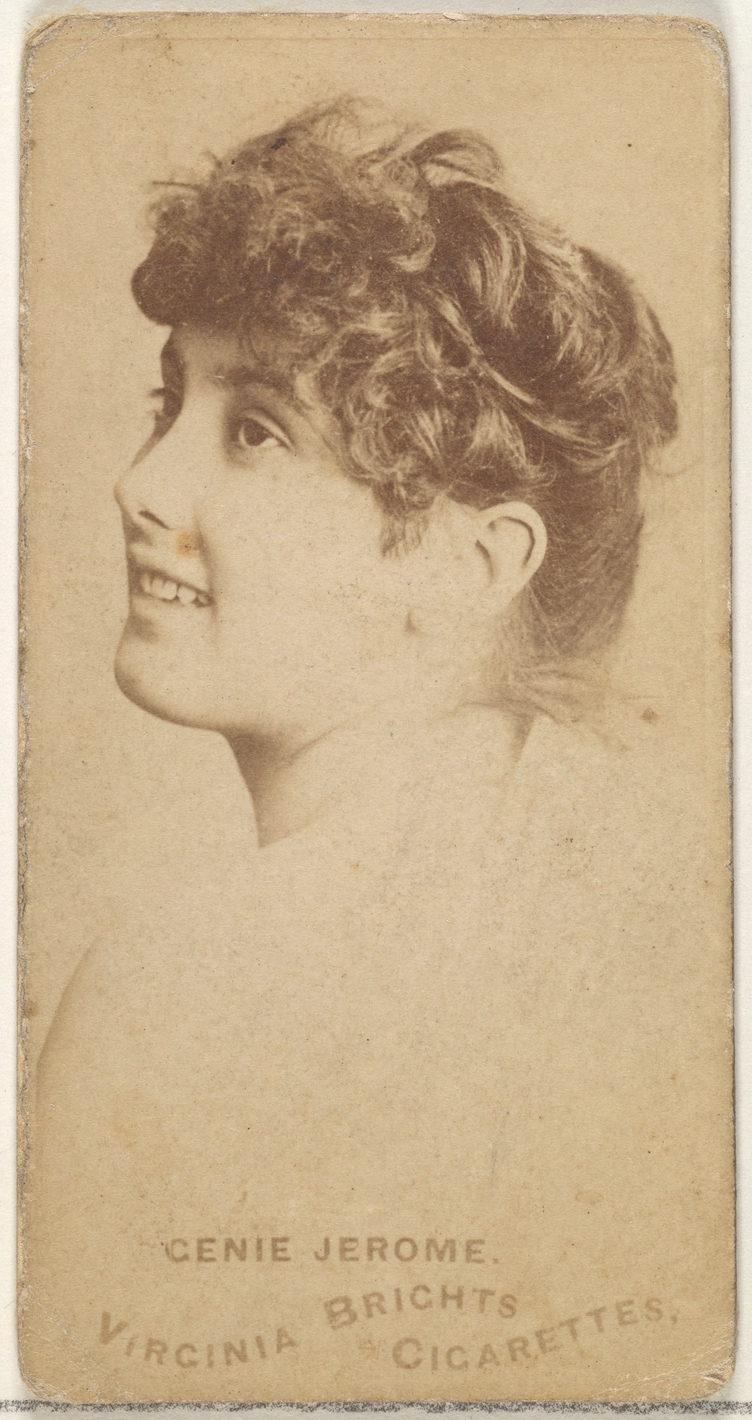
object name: photograph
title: Genie Jerome, from the Actors and Actresses series (N45, Type 1) for Virginia Brights Cigarettes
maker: allen & ginter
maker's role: publisher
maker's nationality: american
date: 1888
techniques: albumen silver print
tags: portraits,profiles,women,actresses